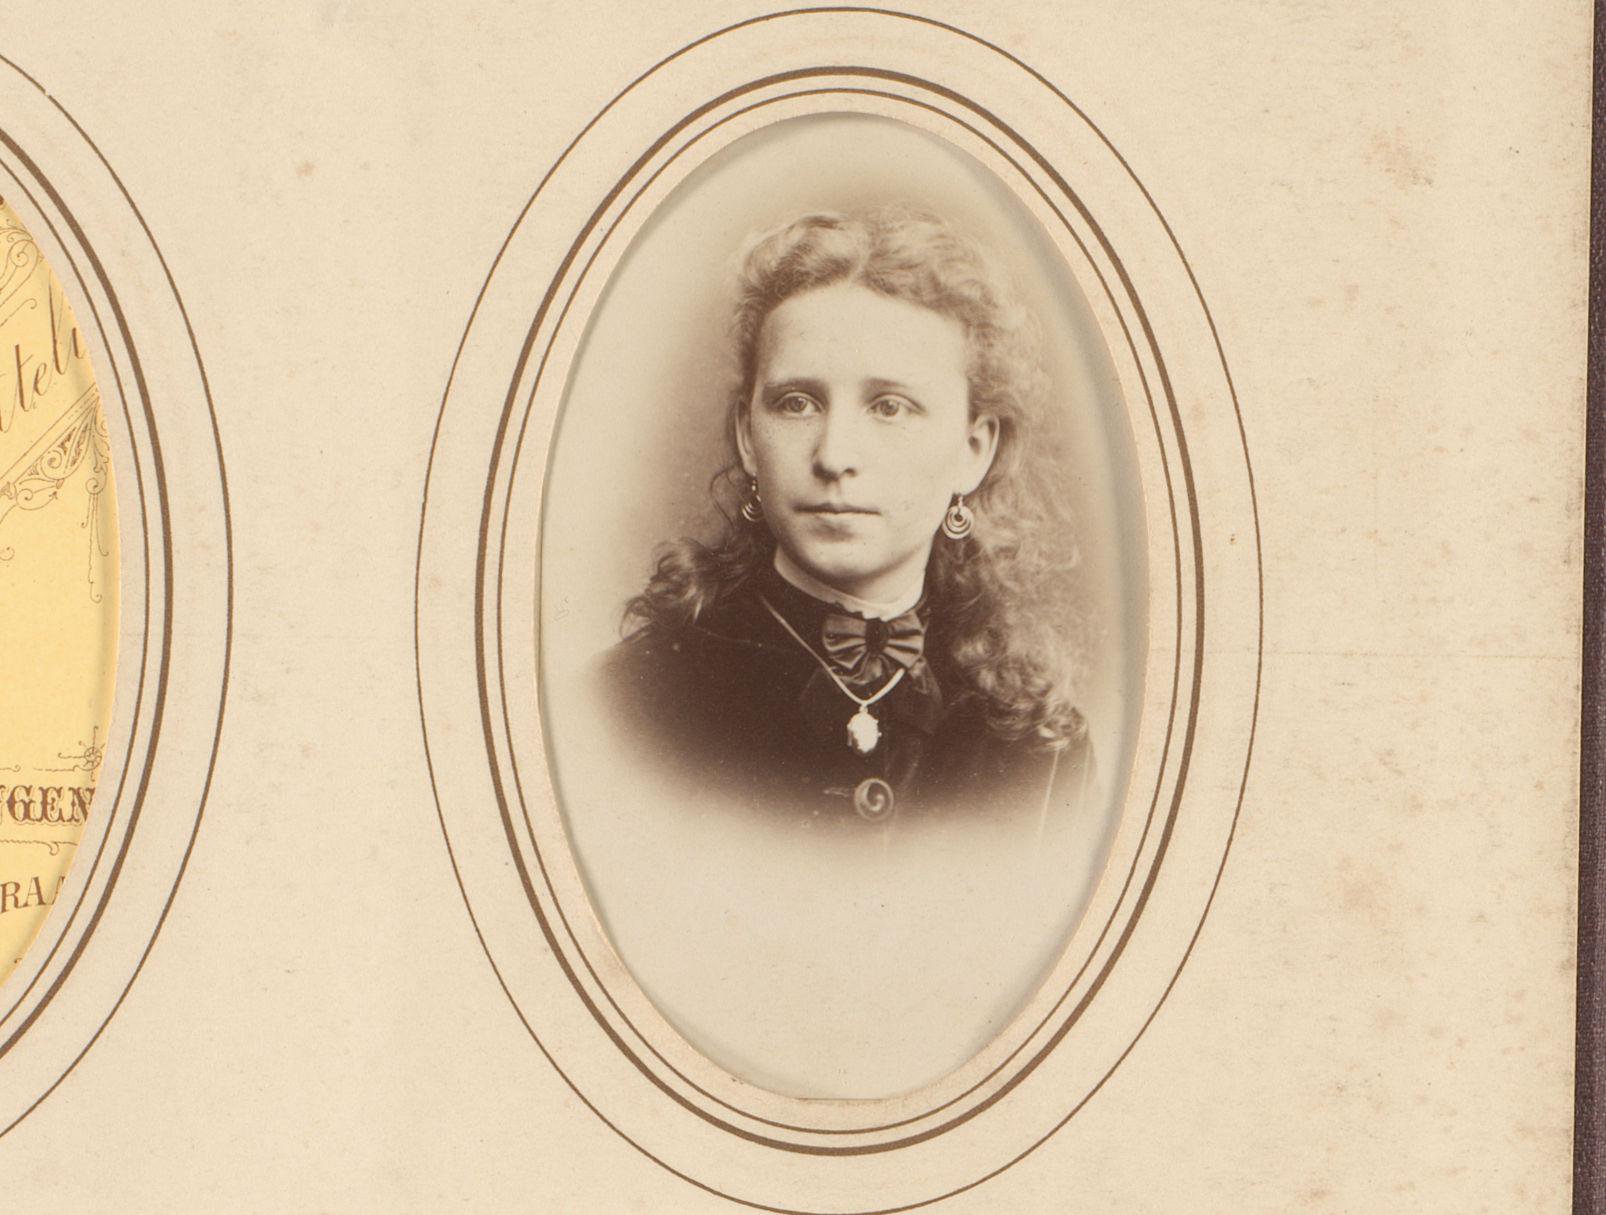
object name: carte de visite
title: Portret van een vrouw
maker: george lodewijk mulder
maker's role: fotograaf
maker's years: 1841-1920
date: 1870-1890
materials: cardboard, photographic support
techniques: albumen print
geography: utrecht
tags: adult woman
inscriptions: inscription: ‘G.L. Mulder / Utrecht’, inscription: ‘G.L. Mulder / van Wijckskade H. 326 / Utrecht. / Photogr. Atelier / GLM’